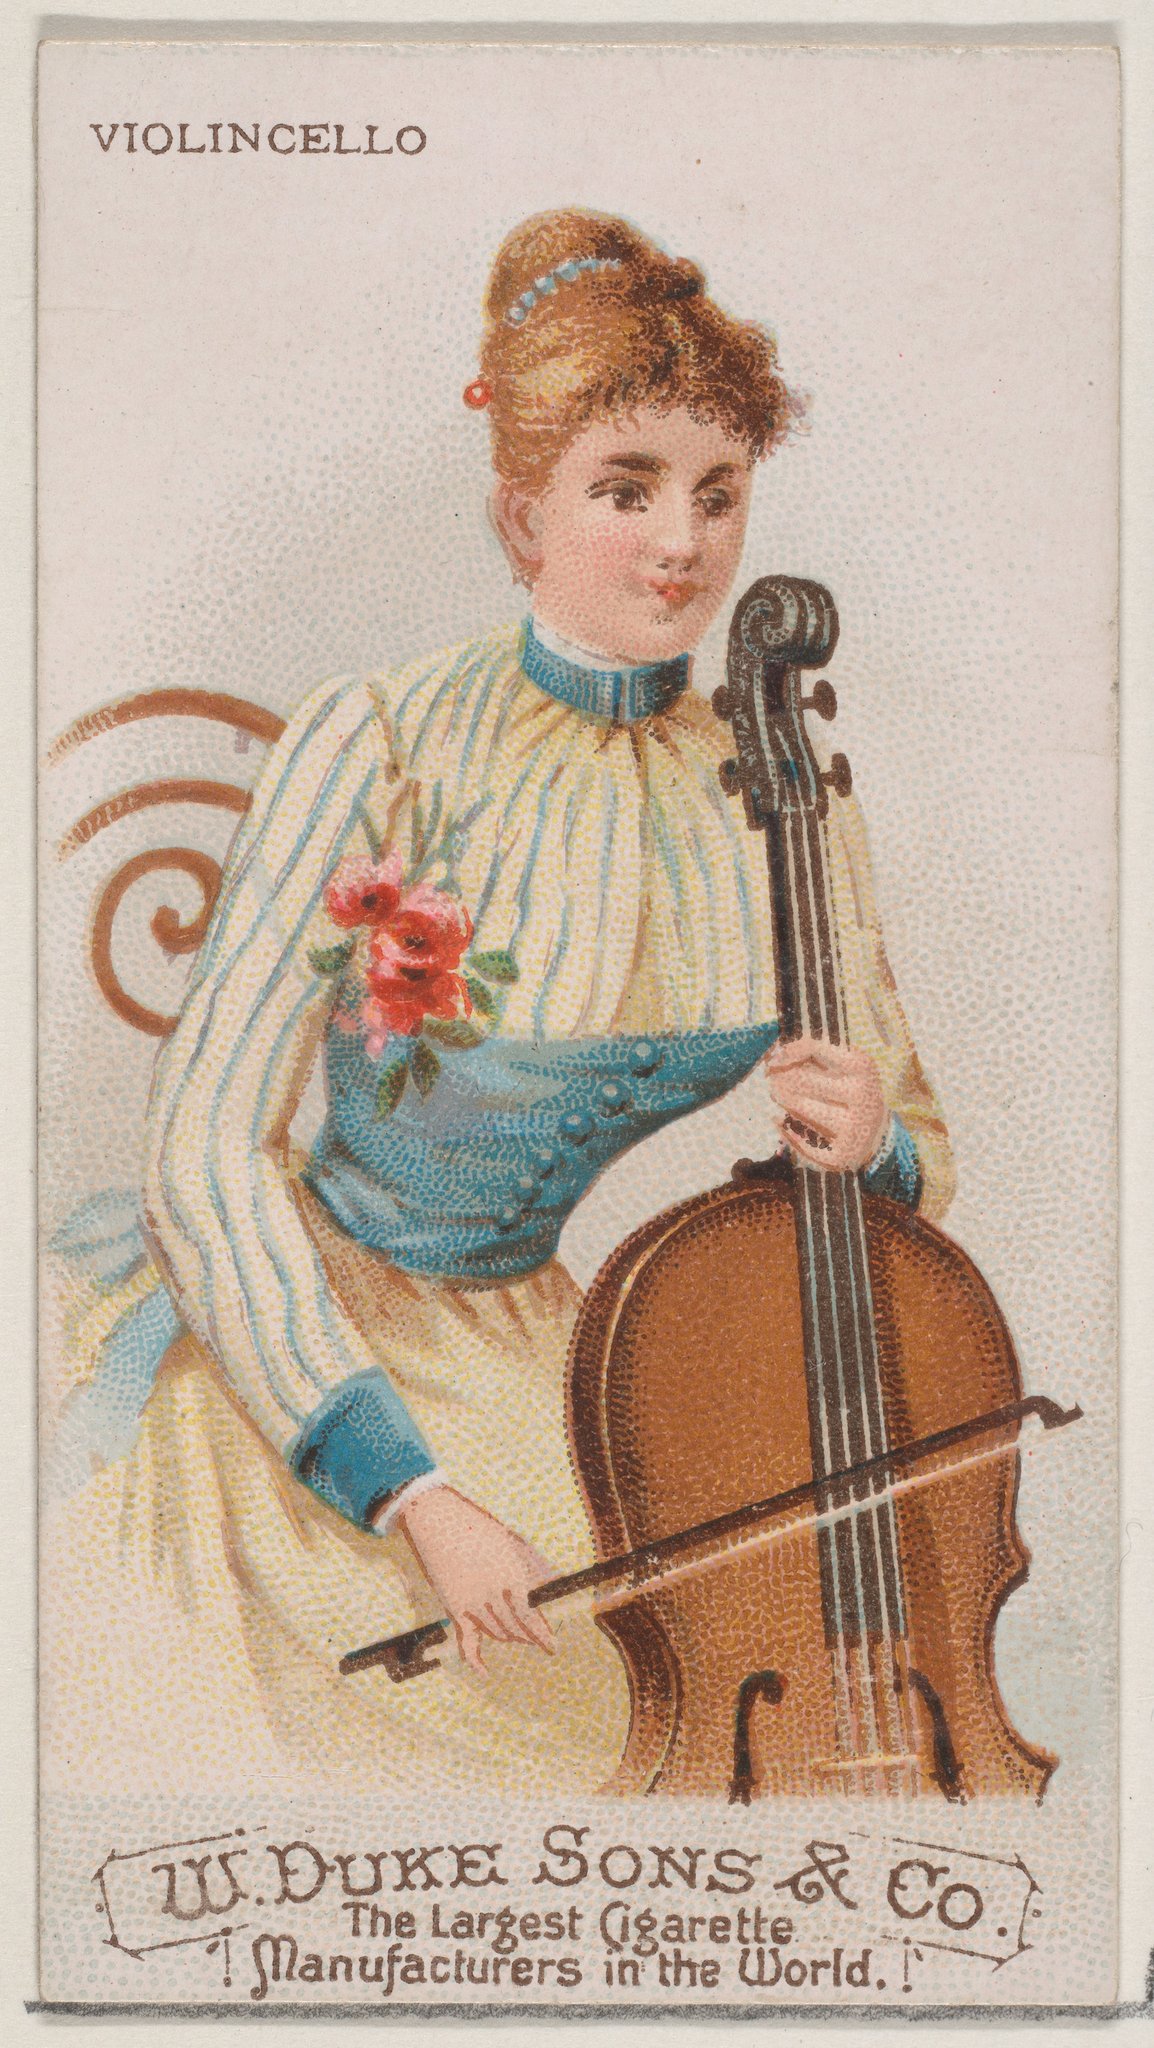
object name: print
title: Cello, from the Musical Instruments series (N82) for Duke brand cigarettes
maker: w. duke, sons & co.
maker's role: publisher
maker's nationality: american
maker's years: 1870-1920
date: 1888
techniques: color lithograph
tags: women,cellos,musicians